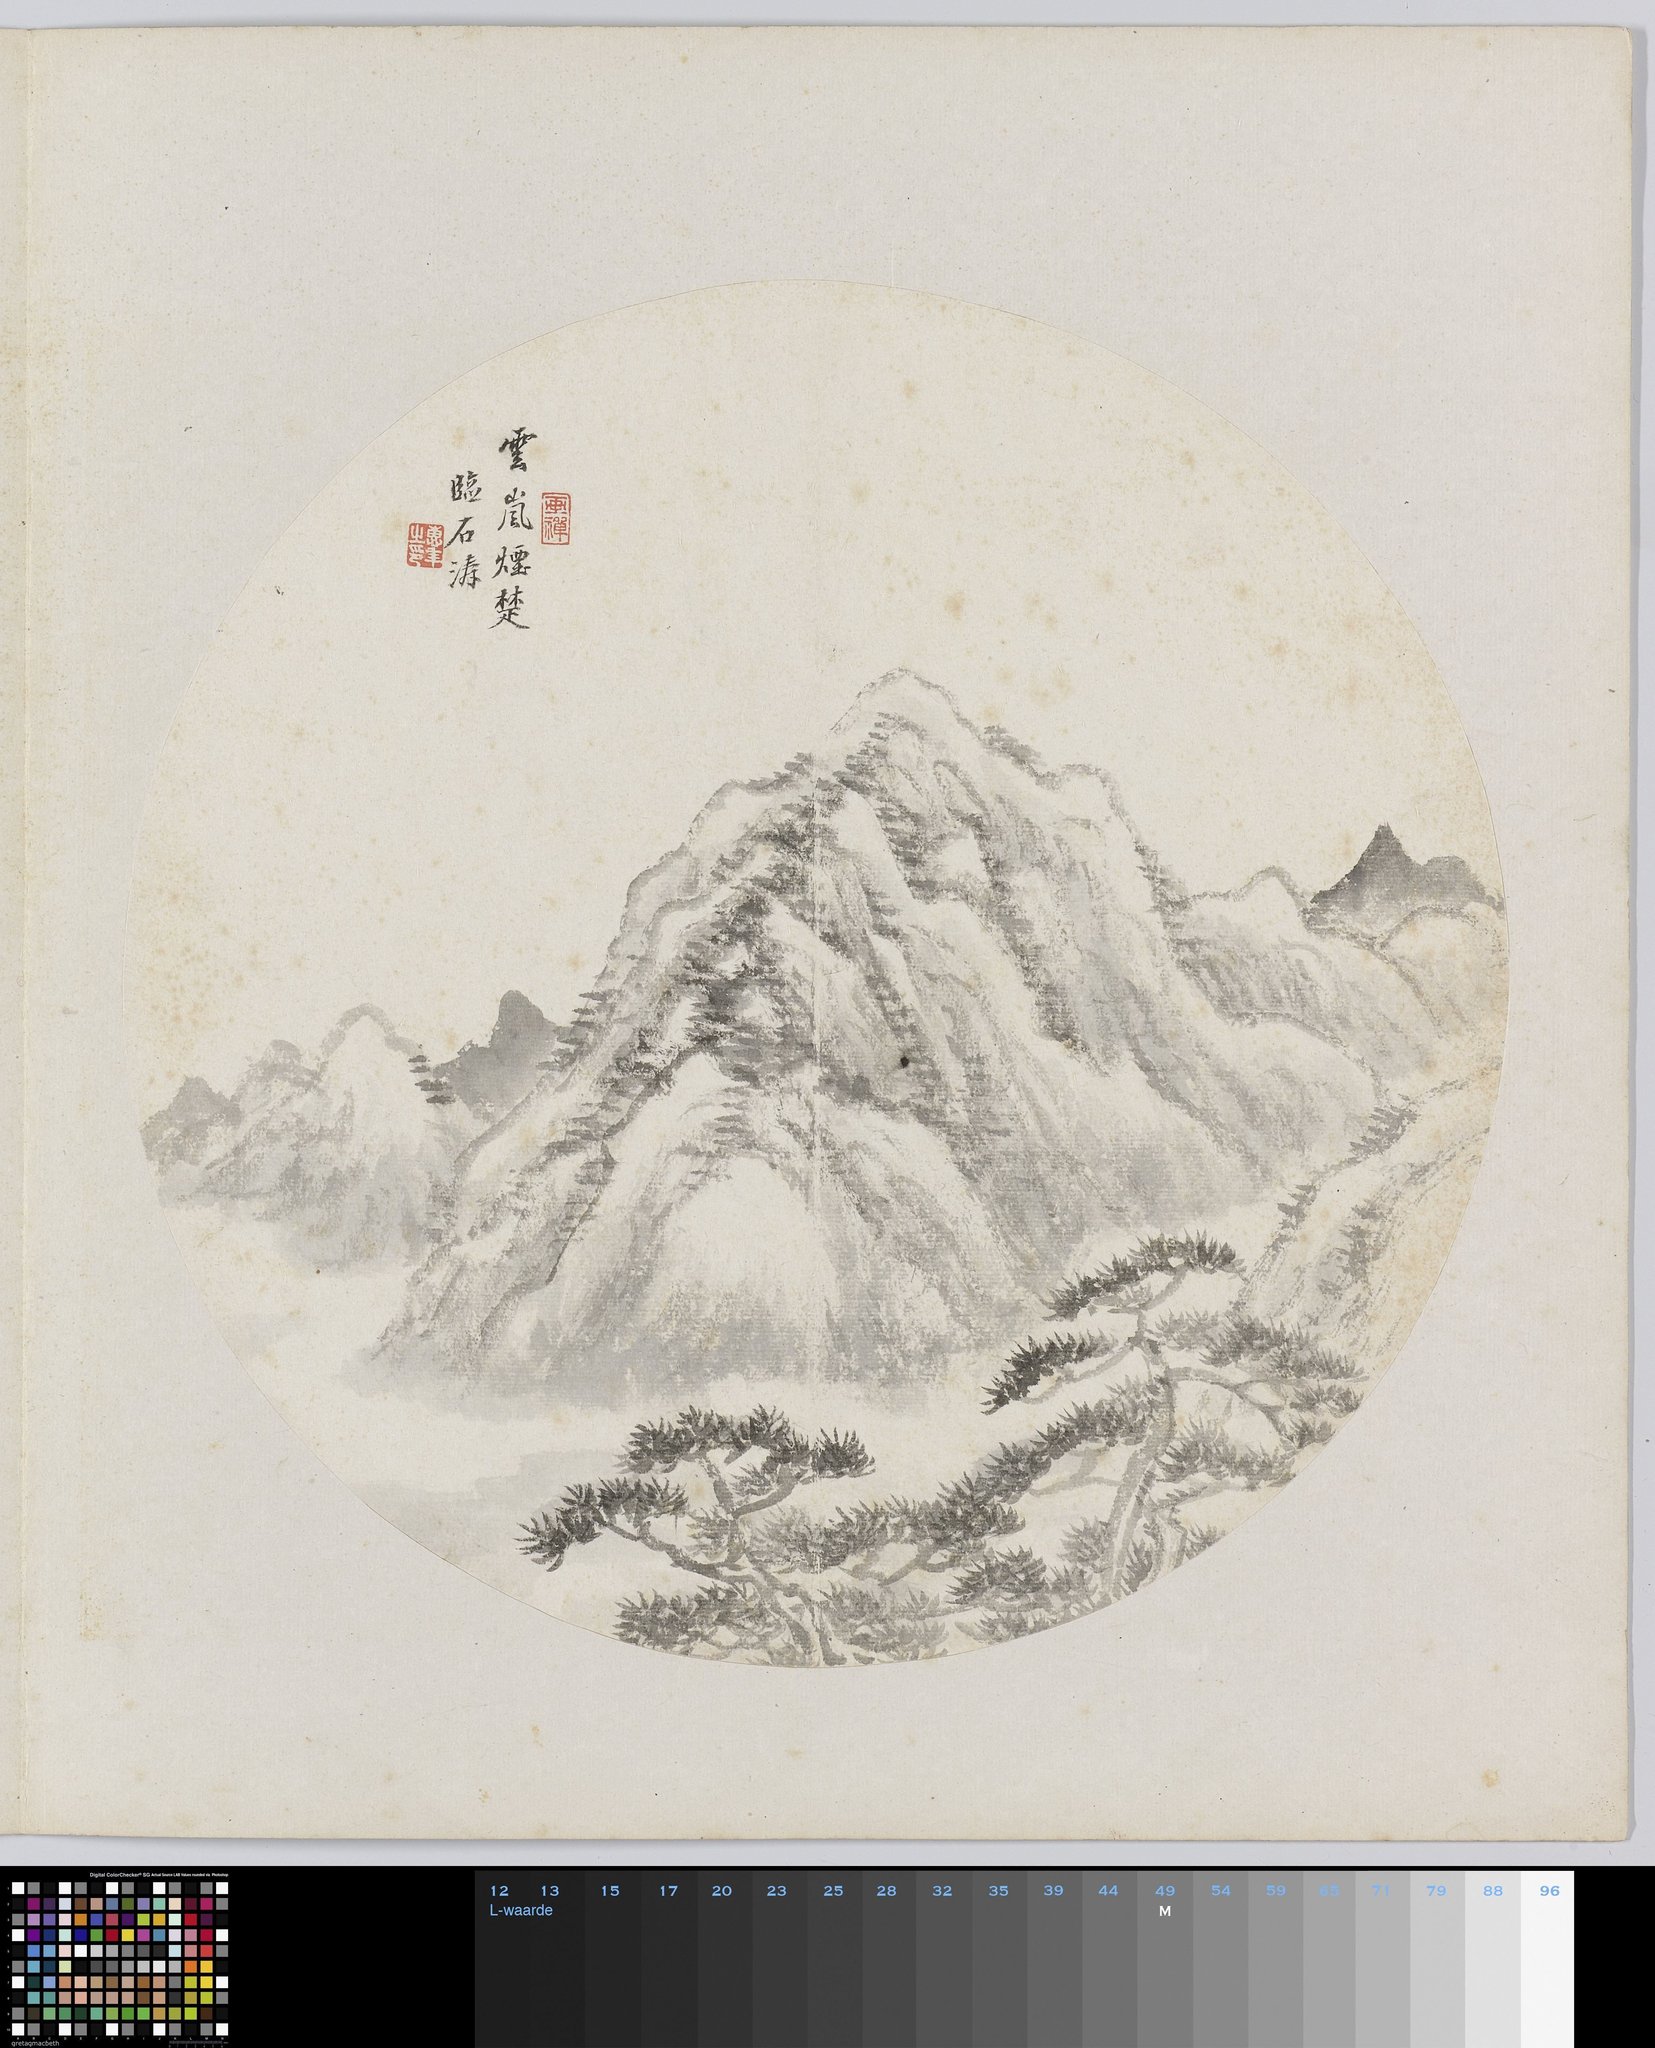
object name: album leaf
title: Albumblad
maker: hui nian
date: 1850-1900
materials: ink, paper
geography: china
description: Albumblad met een landschap. Behoort twee albums met 24 landschappen in de stijl van diverse meesters.